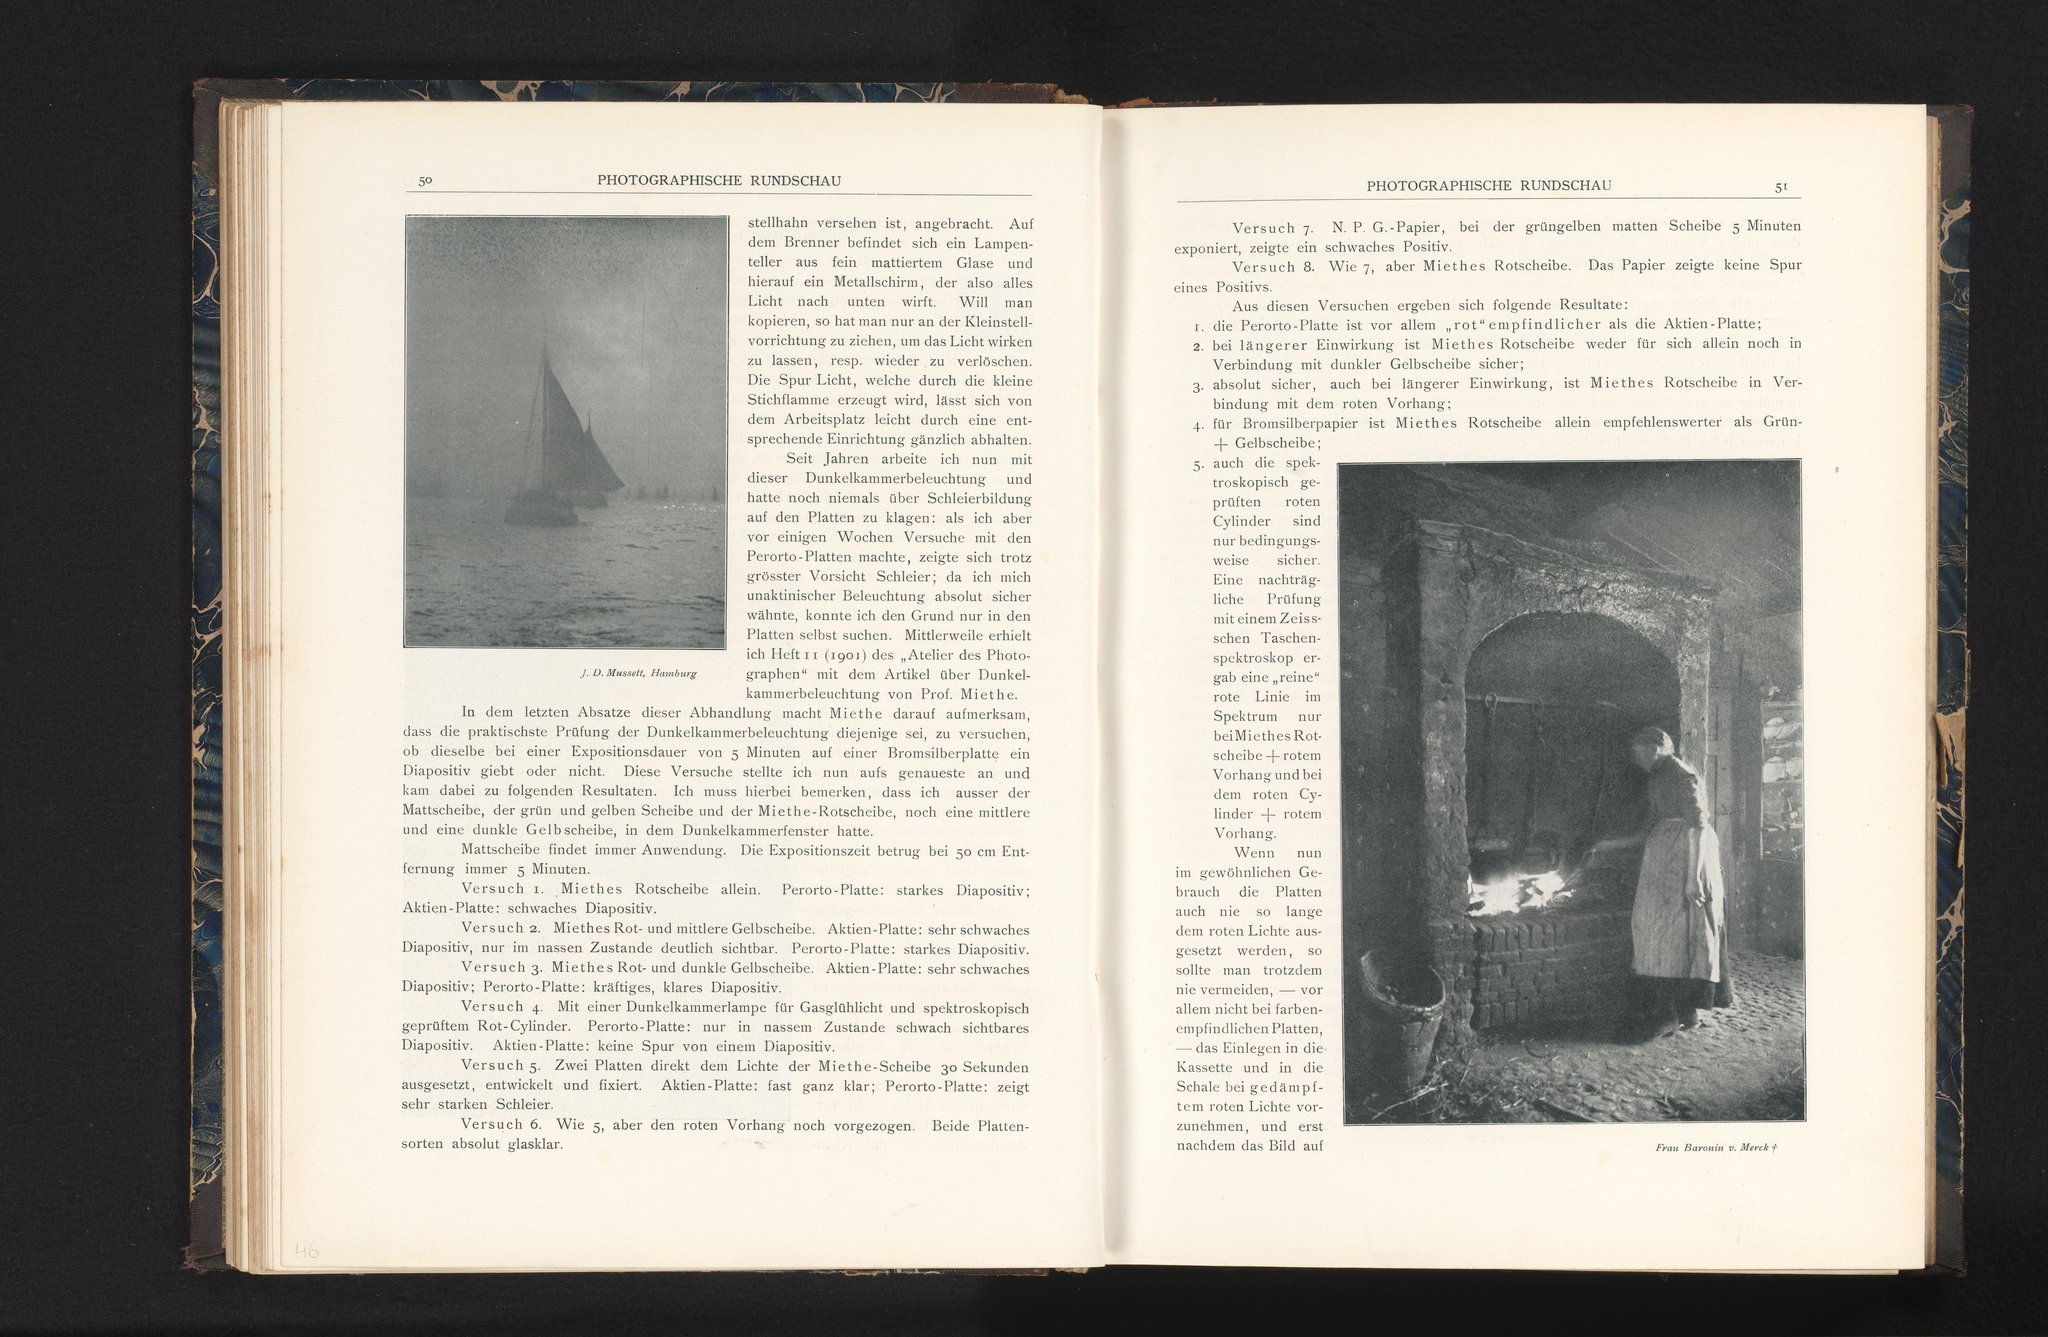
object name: photomechanical print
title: Gezicht op een zeilboot te water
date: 1897-1902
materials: paper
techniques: autotype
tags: sailing-ship, sailing-boat, landscapes with waters, waterscapes, seascapes (in the temperate zone)